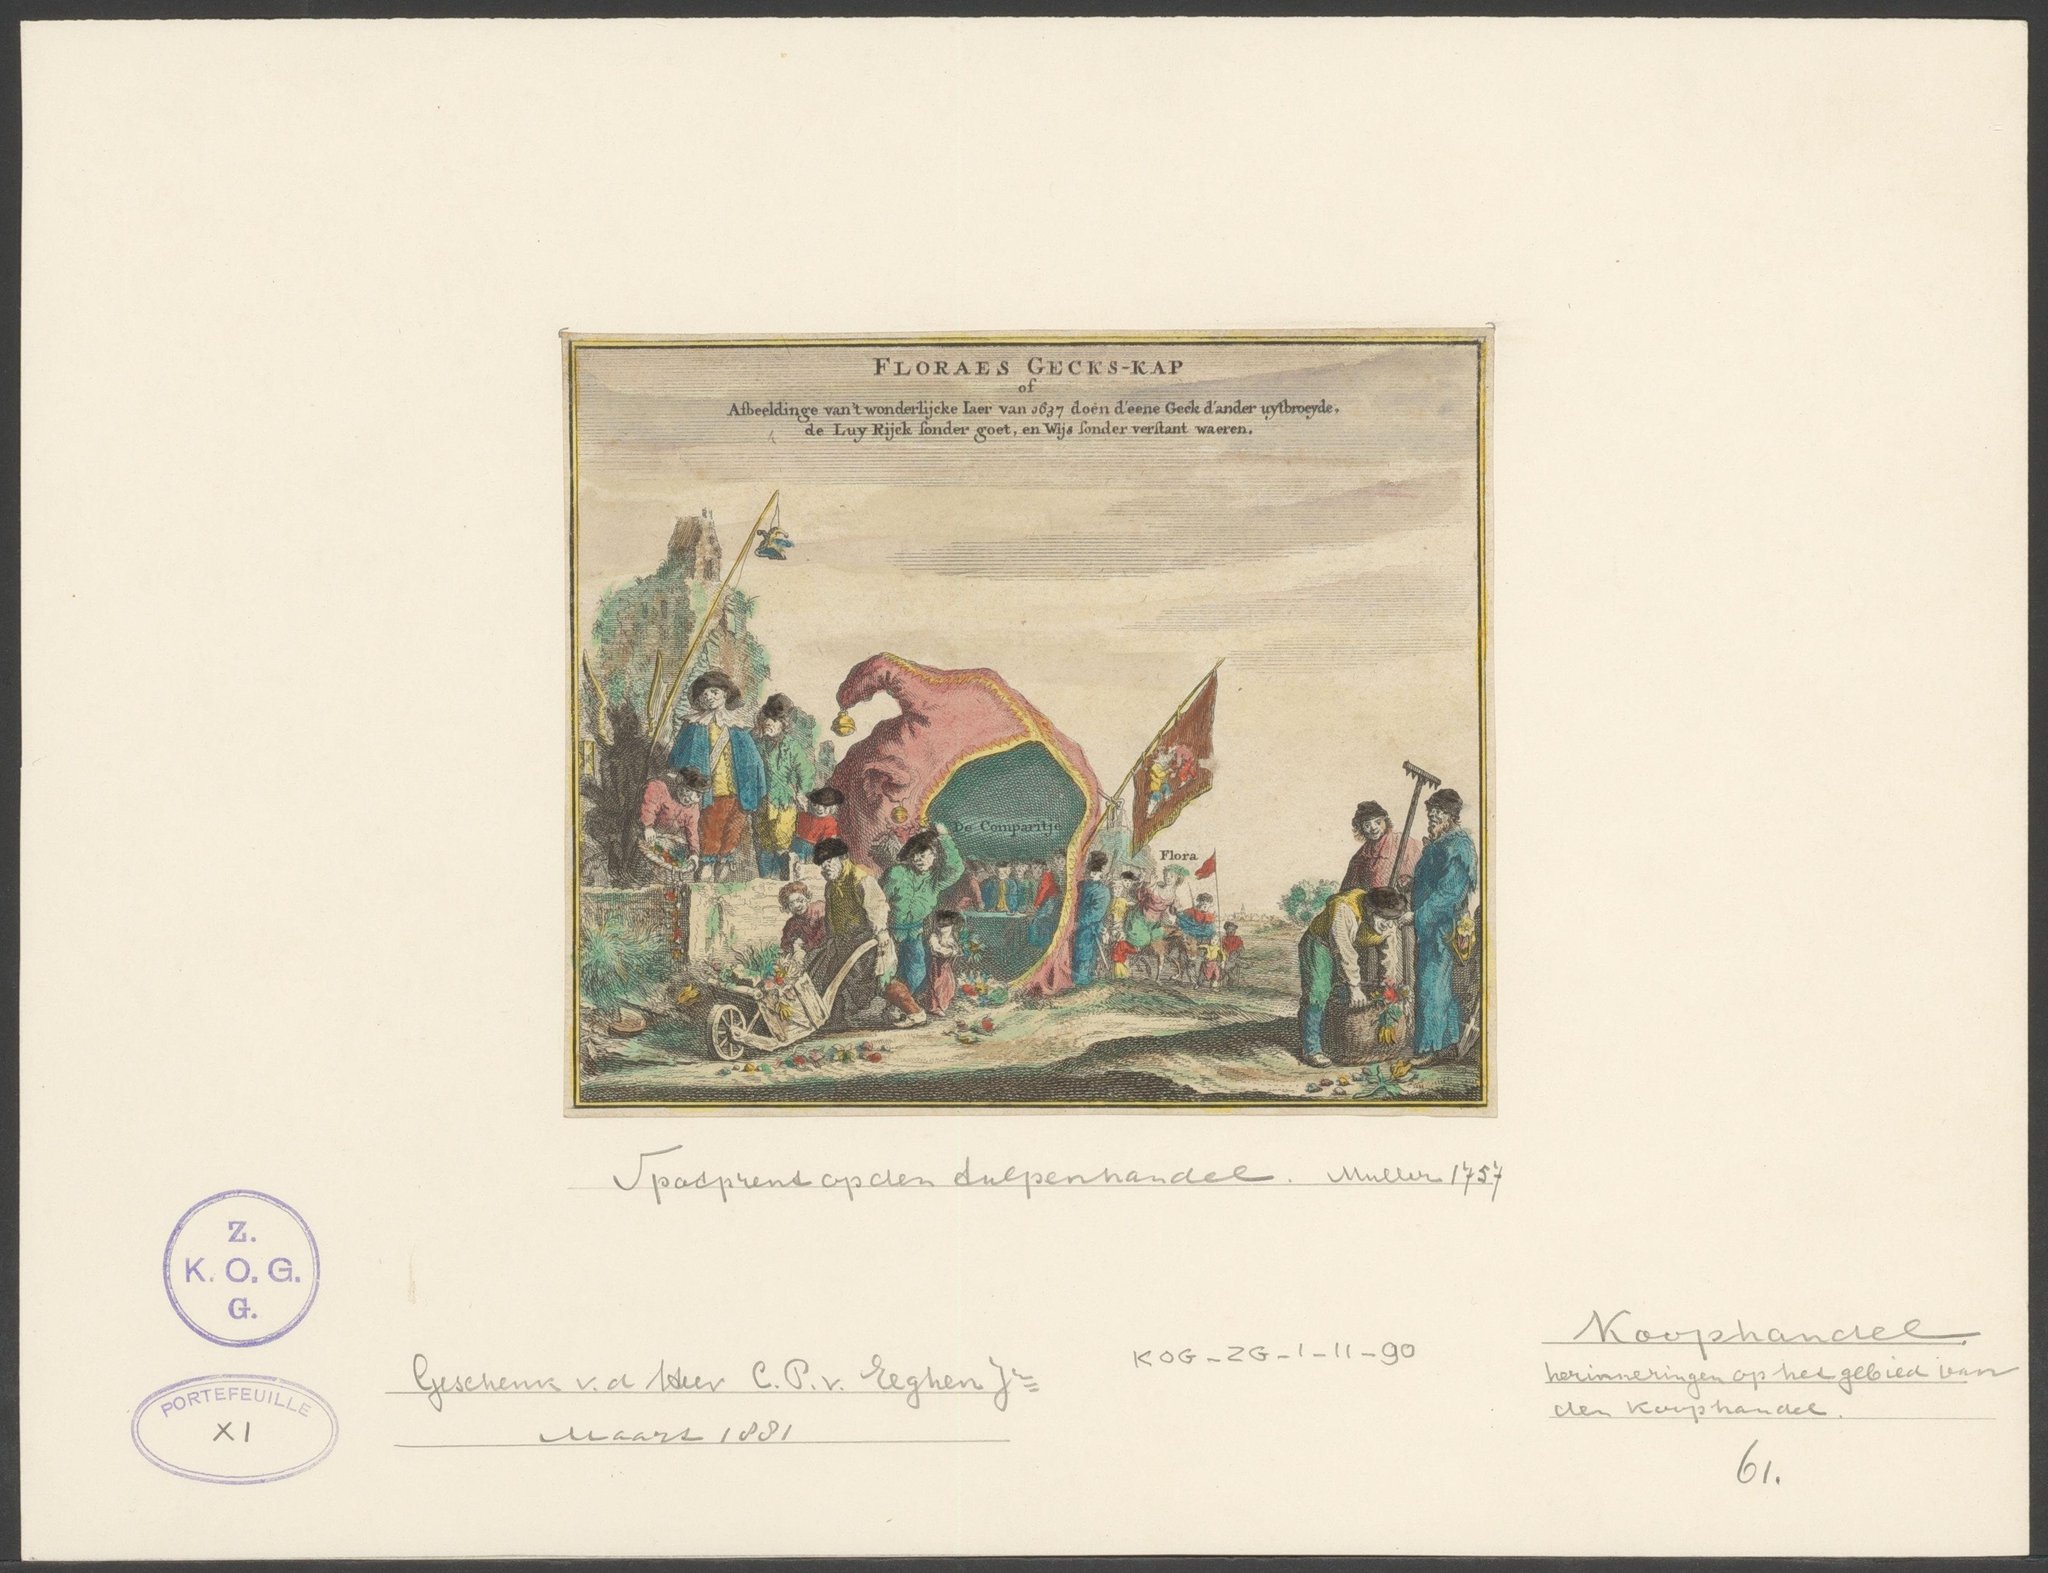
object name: print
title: Spotprent op de tulpenhandel, 1637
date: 1754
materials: paper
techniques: etching, hand coloring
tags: speculative boom, negative results and undesired aspects of trading, (story of) flora - suffering, misfortune, fool's cap, flowers: tulip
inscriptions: stamp, collector's mark: Lugt 1641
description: Spotprent op de tulpenmanie, windhandel in tulpenbollen in het jaar 1637. In een herberg in de vorm van een grote narrenkap zitten tulpenhandelaren. Links op een verhoging staat de duivel met een zandloper, handelaren met een stok met inschrijvingen en een boer die een mand met bollen op de mesthoop omkeert. Daarvoor en rechtsvoor verschillende bollenboeren. Op de achtergrond wordt Flora gezeten op een ezel weggejaagd. Onderwerpsrubrieken binnen de Atlas Zeden en Gewoonten: Handel, nijverheid en verkeer, Koophandel, Veilingen, Makelaardij en Verzekeringswezen, Herinneringen op het gebied van den Koophandel.